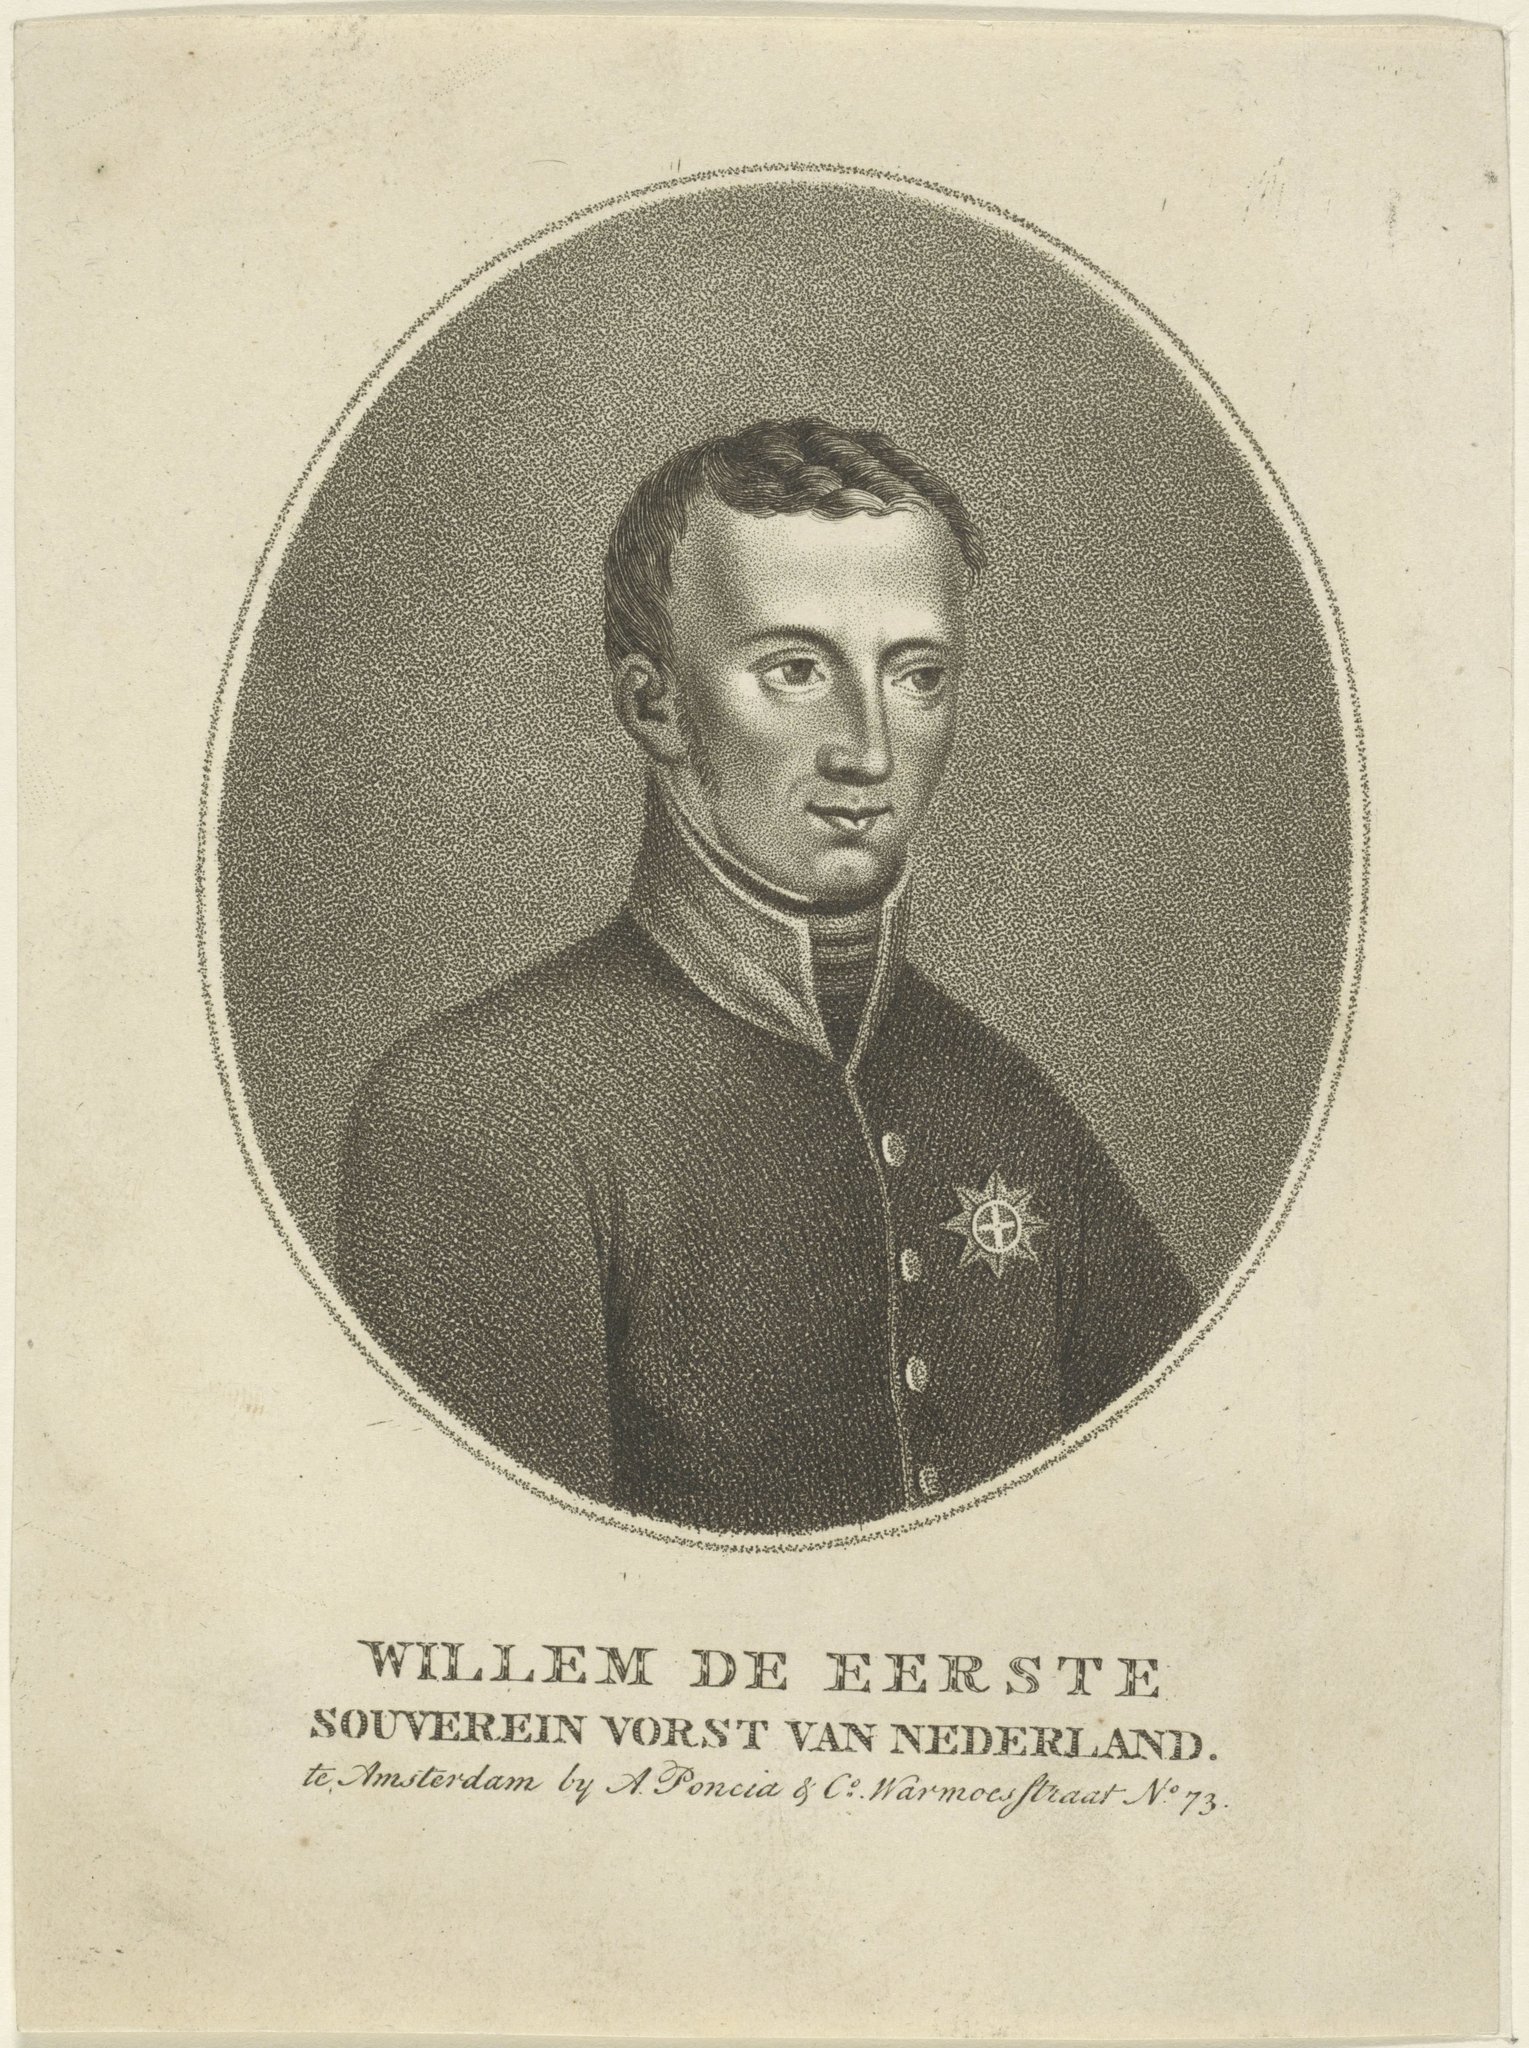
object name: print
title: Portret van Willem I Frederik, koning der Nederlanden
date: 1813-1815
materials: paper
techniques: engraving, etching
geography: netherlands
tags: the hague, william i of the netherlands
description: De hier vermelde titel verwijst naar de hoogst verkregen titel van de geportretteerde, niet per se naar de titel die de geportretteerde op deze voorstelling draagt.